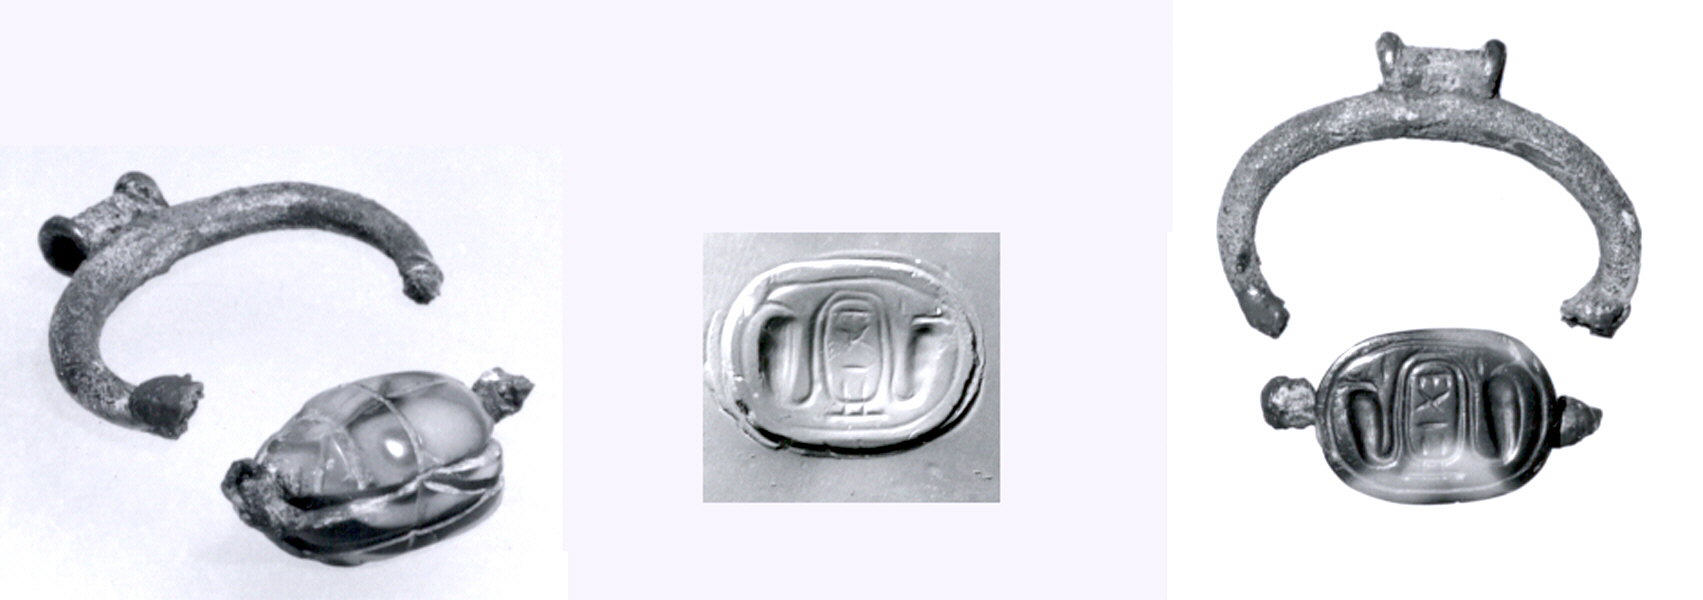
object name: ring, pendant, with scarab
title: Silver pendant ring with agate scarab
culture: cypro-phoenician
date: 500-301 BCE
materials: stone, silver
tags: scarabs